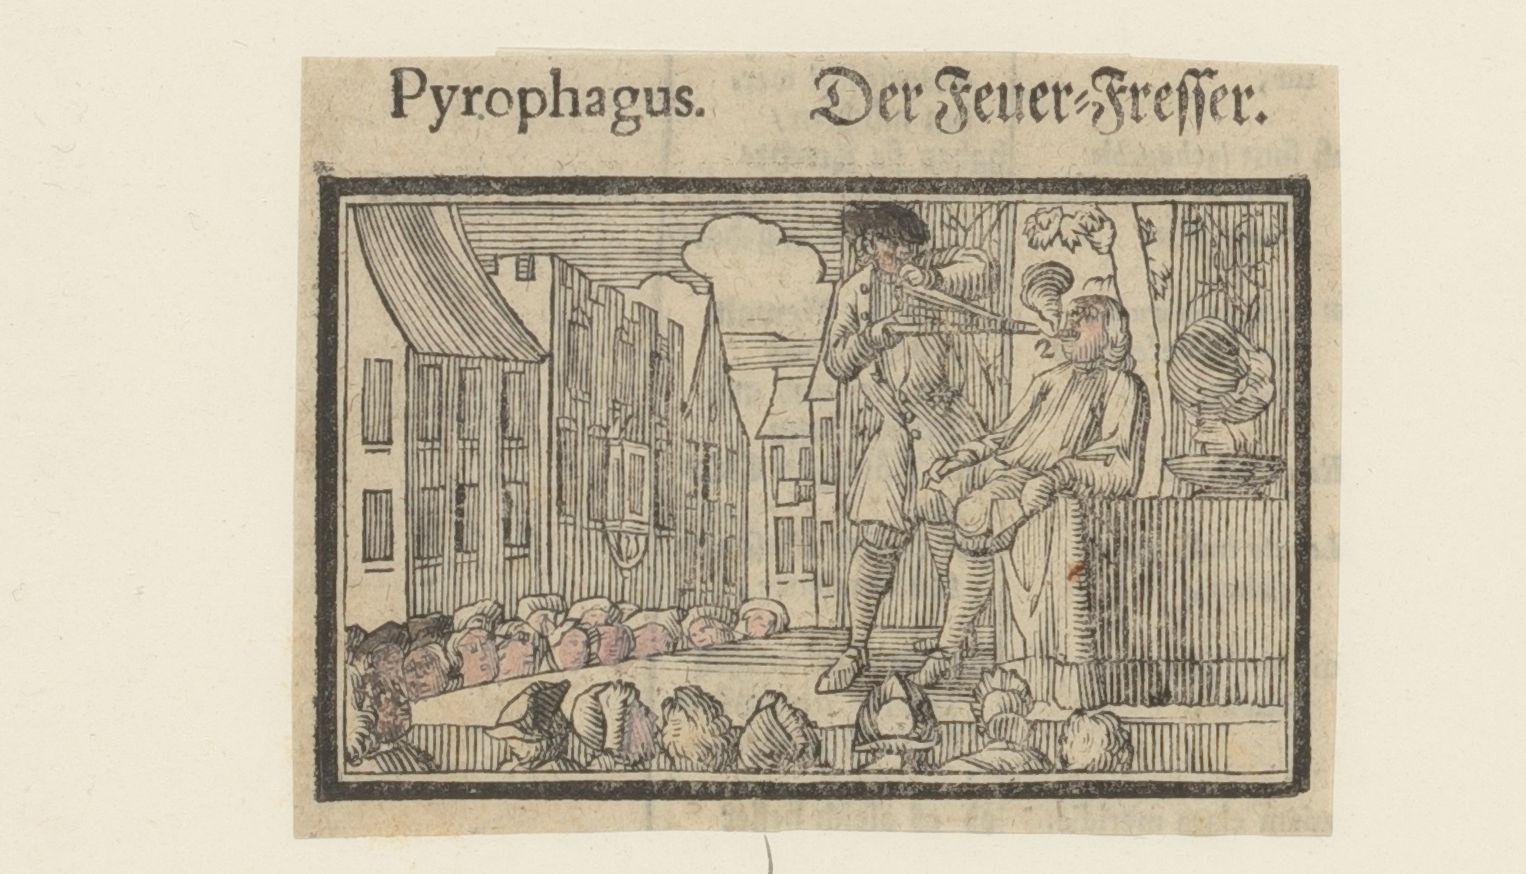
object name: book illustration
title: Pyrophagus. Der Feuer-Fresser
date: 1719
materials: paper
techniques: hand coloring, letterpress printing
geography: nuremberg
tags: fire-eater, handicrafts, craftsman at work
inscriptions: stamp, collector's mark: Lugt 1641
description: Op een plein kijkt het publiek naar een vuurvreter op een podium. Hij heeft een brandende kool op zijn tong, waarmee een mengsel van gesmolten pek, zwavel en was met een blaasbalg in zijn mond wordt aangestoken. Daarna blaast hij de vlammen zijn mond uit. Onderwerpsrubrieken binnen de Atlas Zeden en Gewoonten: Handel, Nijverheid en Verkeer, Beroep en bedrijf, Complete suites.